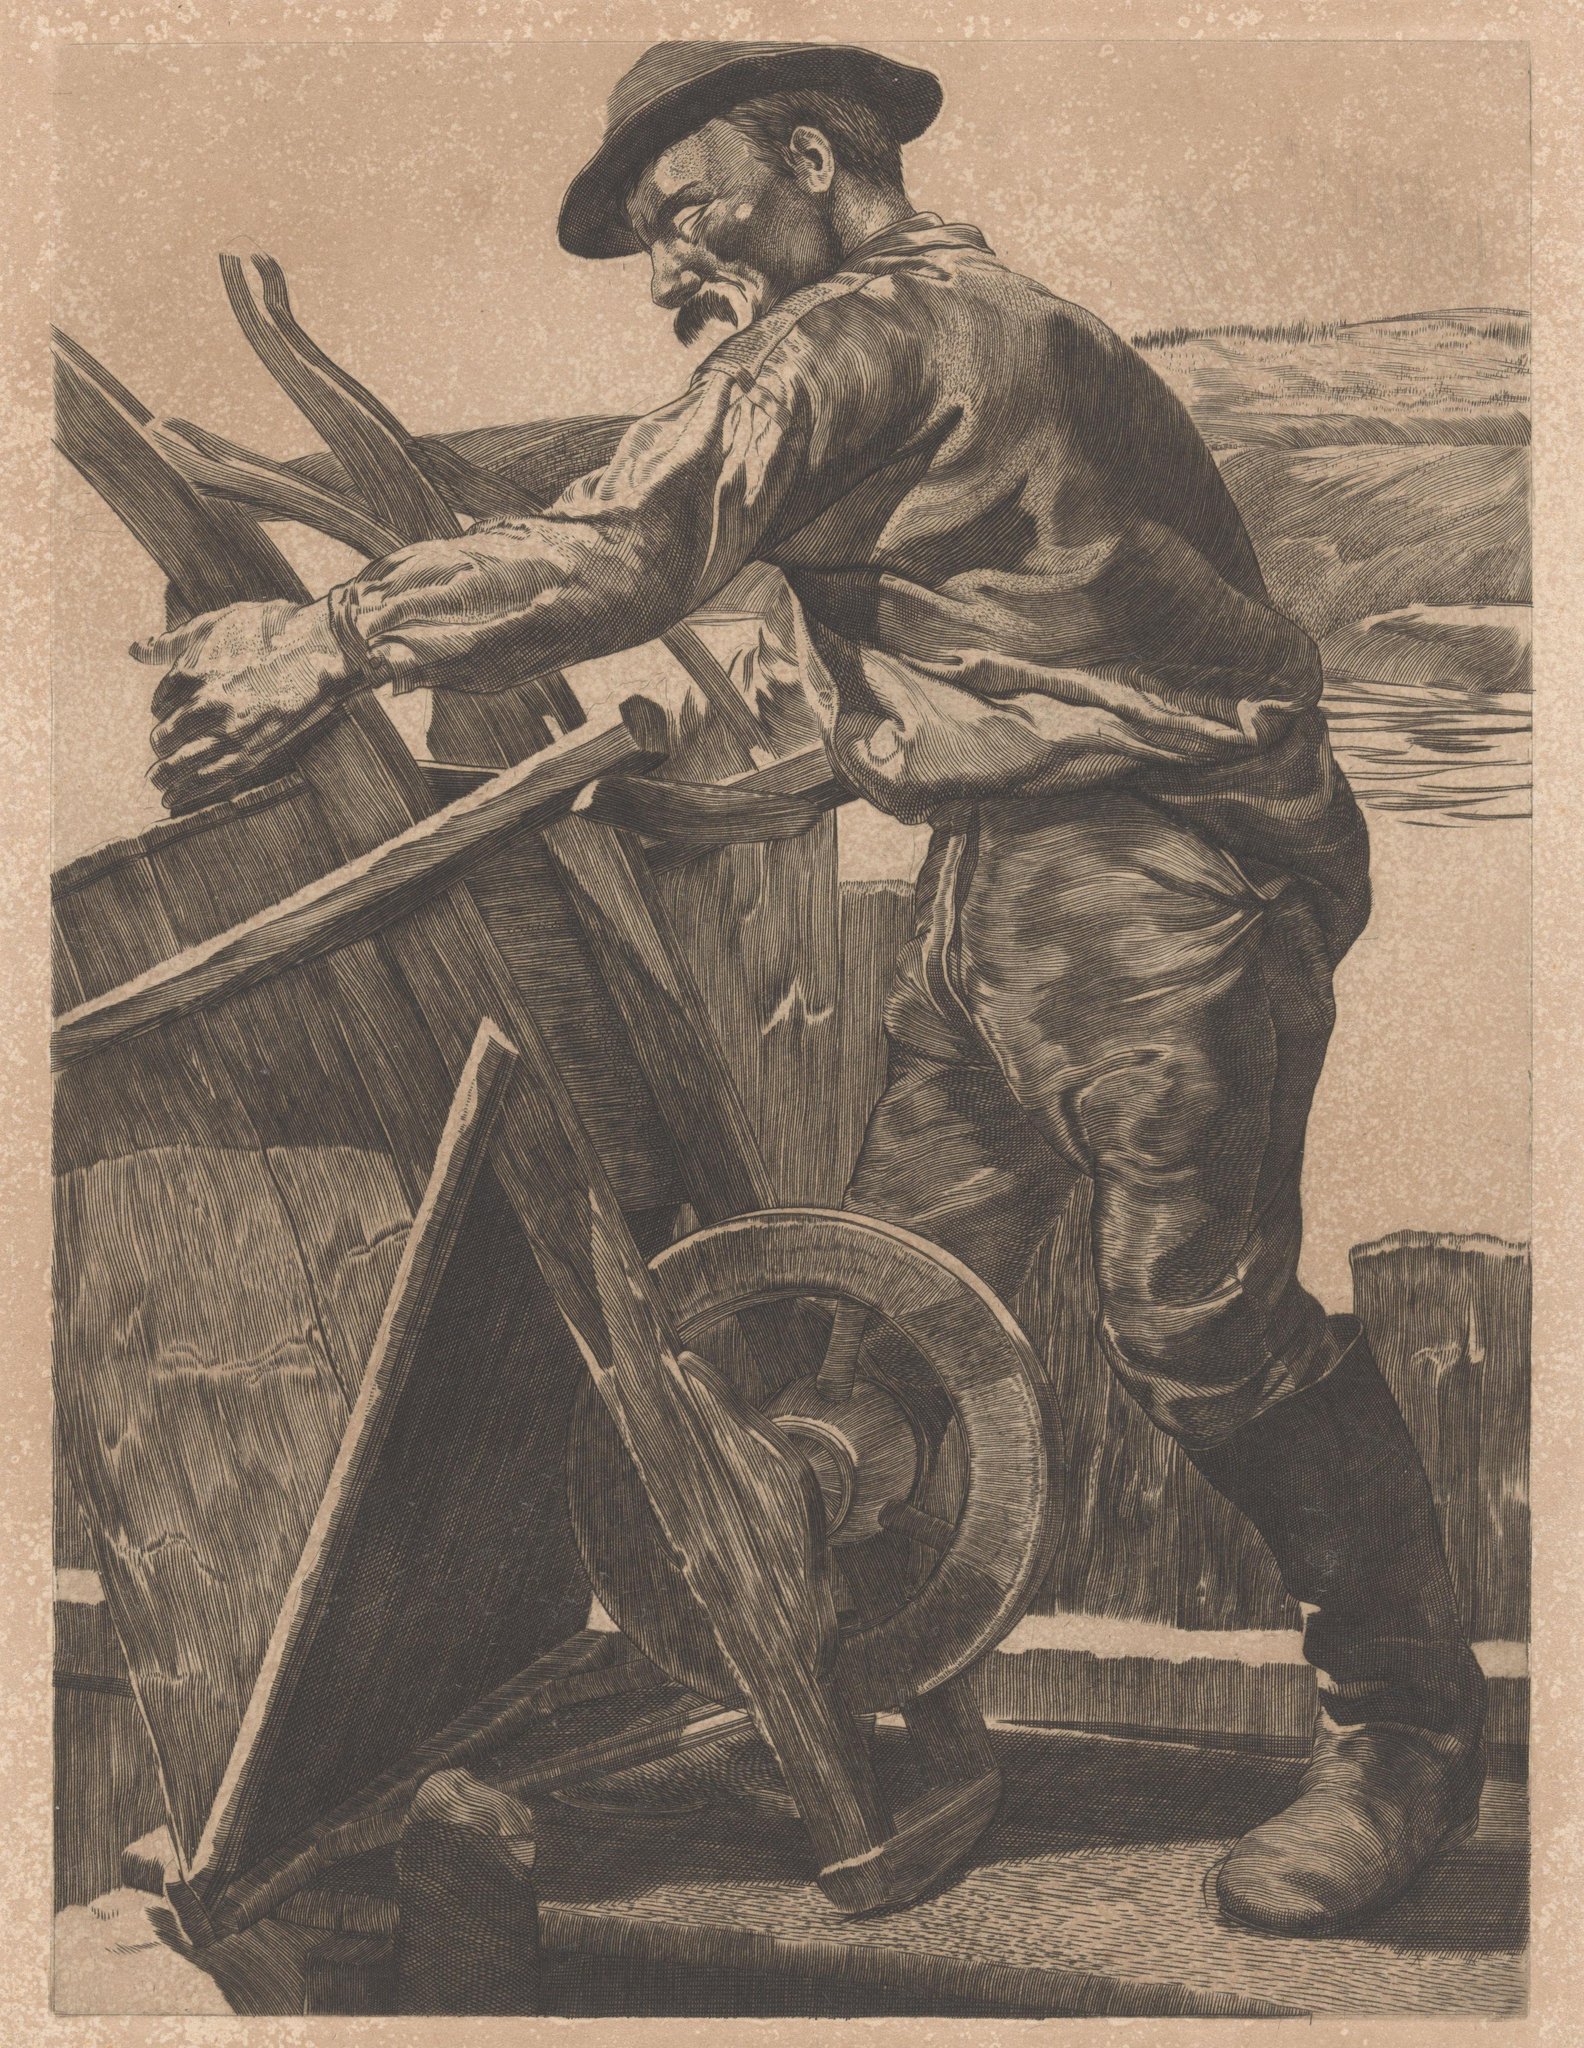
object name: print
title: Arbeider met een kruiwagen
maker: johannes josephus aarts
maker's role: draughtsman, print maker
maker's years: 1871-1934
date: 1881-1934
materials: paper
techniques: aquatint, engraving, intaglio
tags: working class, labourers, wheelbarrow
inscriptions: collector's mark: Lugt 2228, collector's mark: Lugt 2760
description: Een man met hoed keert een houten kruiwagen om. Op de achtergrond water en heuvels.